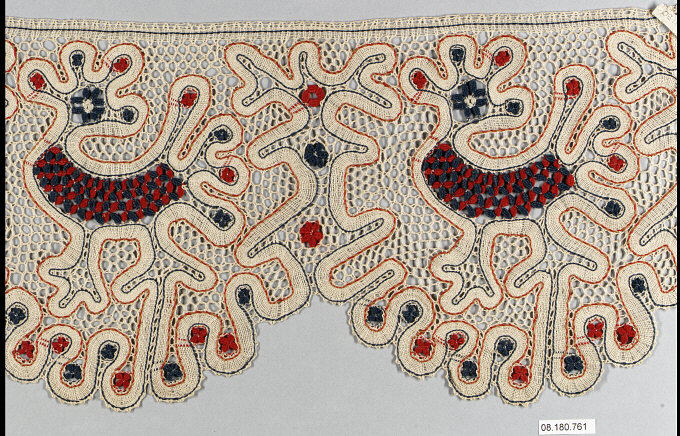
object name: fragment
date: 1801-1900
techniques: lace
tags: birds